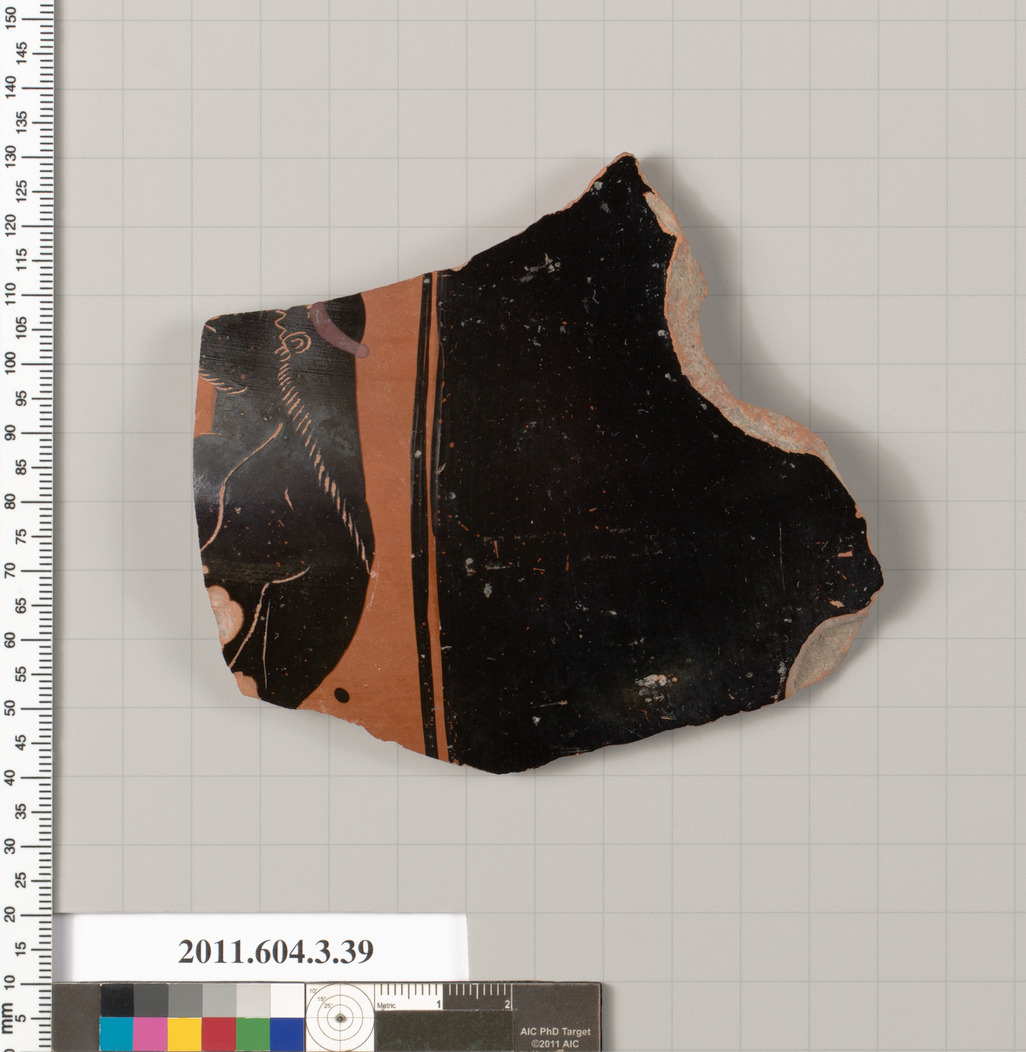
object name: amphora fragment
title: Terracotta fragment of an amphora (jar)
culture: greek, attic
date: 530-520 BCE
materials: terracotta